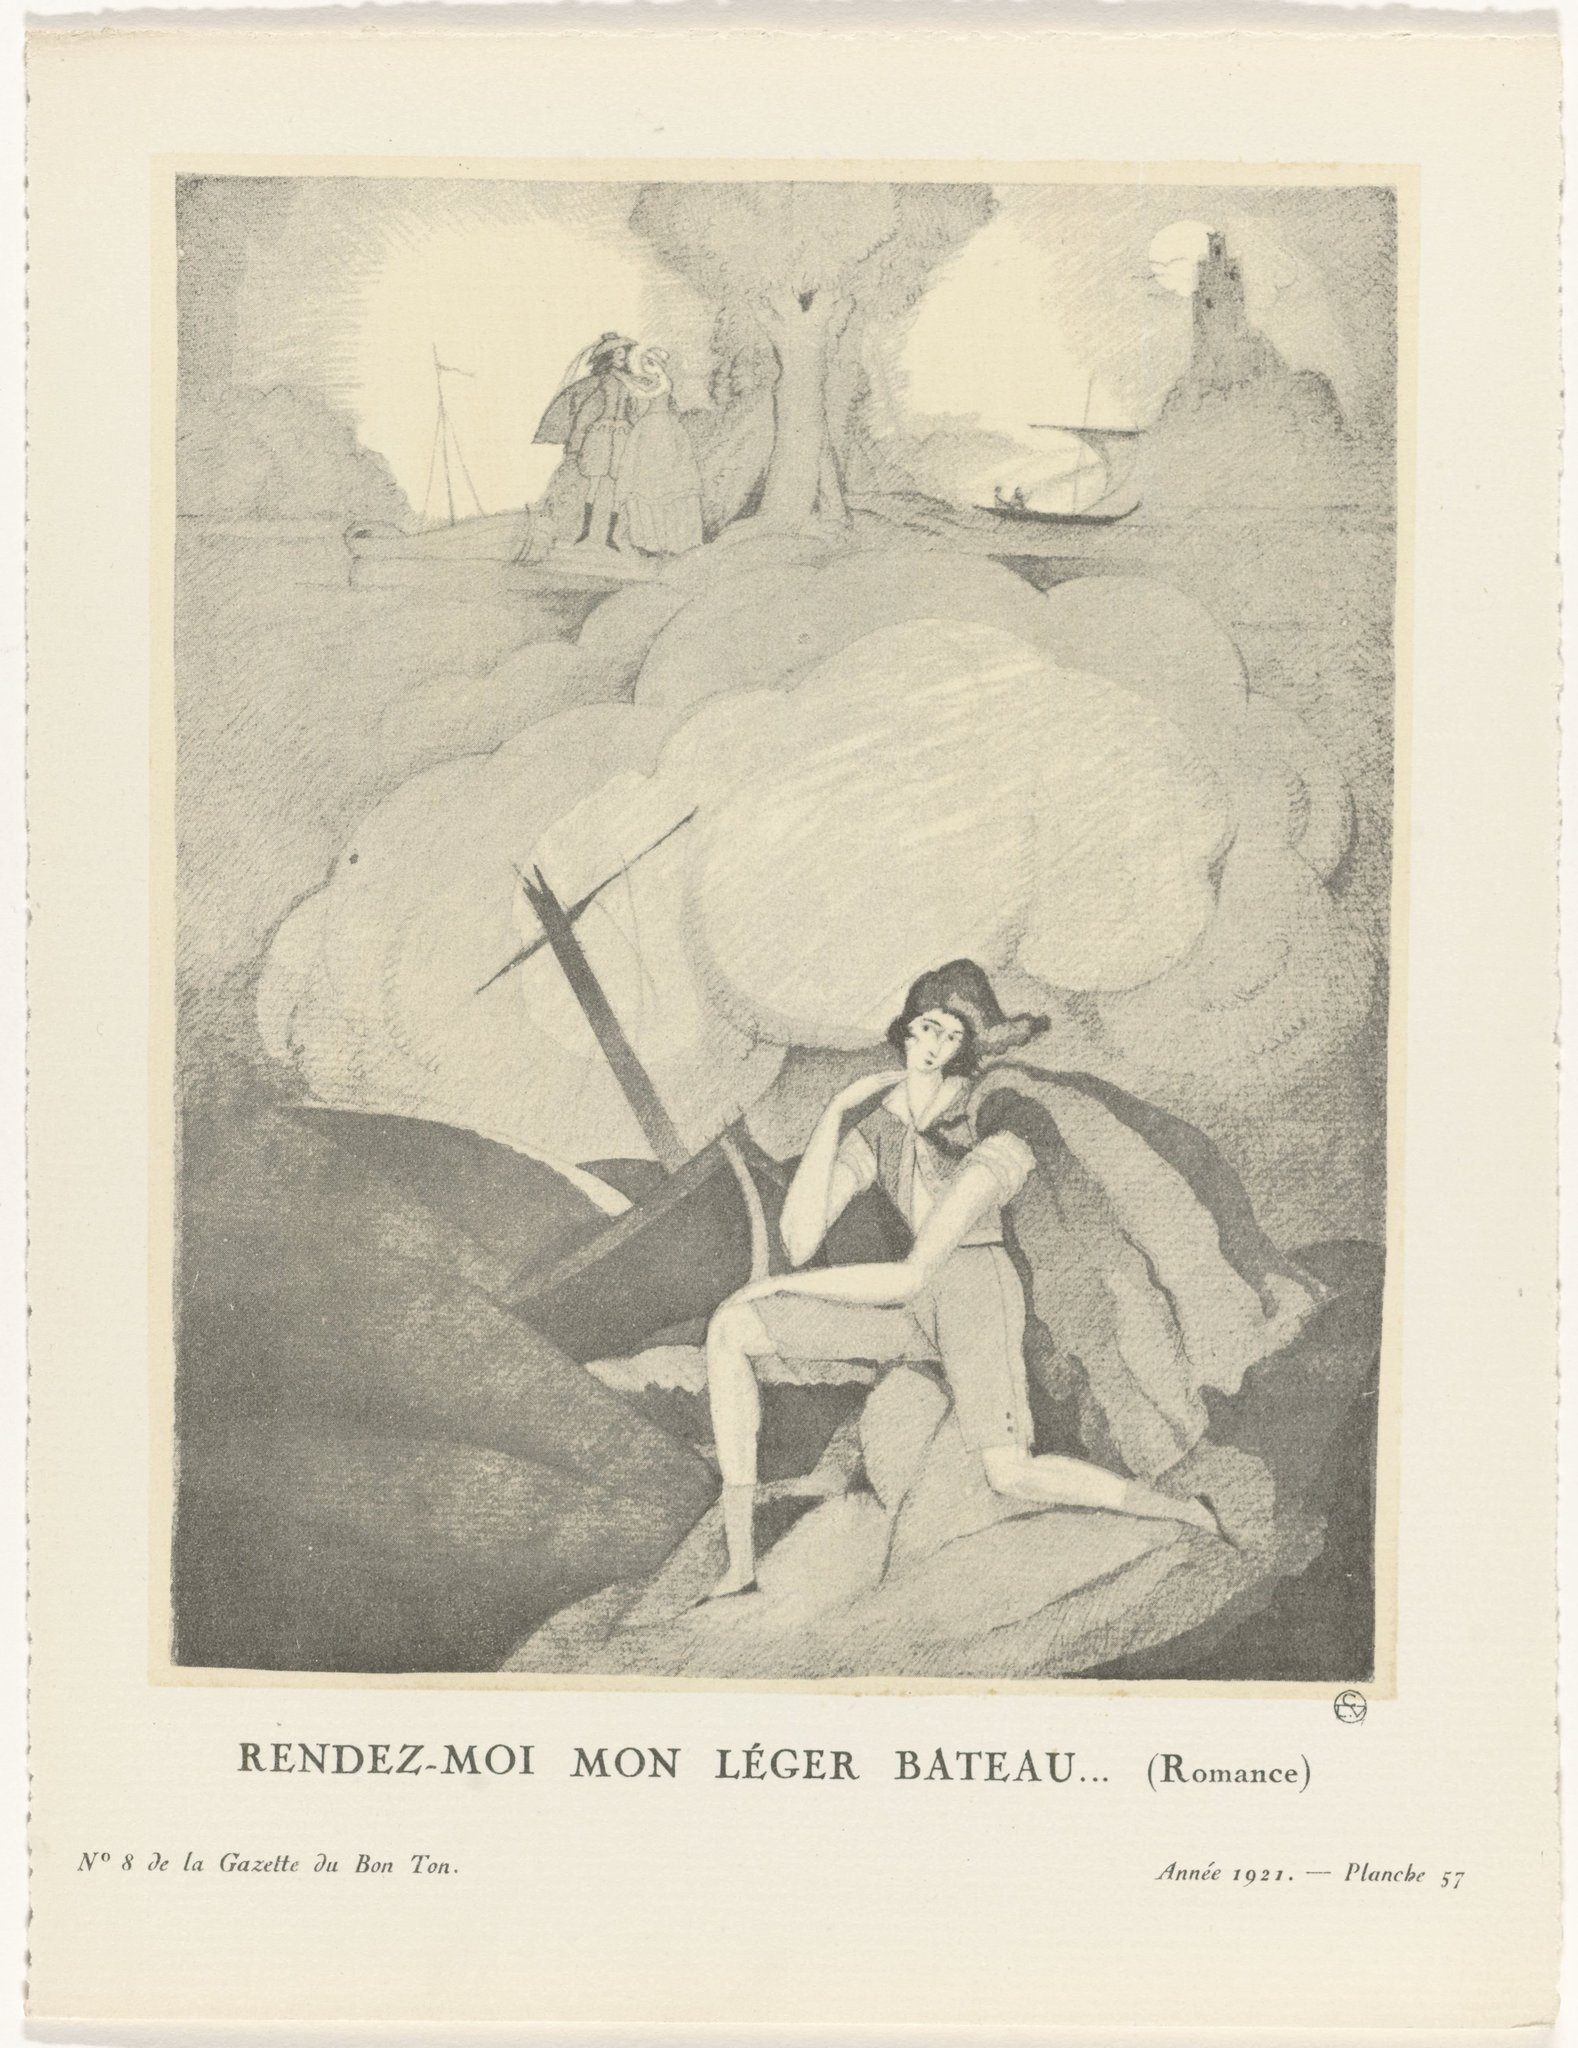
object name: fashion print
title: Gazette du Bon Ton, 1921 - No. 8 : Rendez-moi mon léger bateau... (Romance)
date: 1921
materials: paper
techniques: letterpress printing, photochemical processes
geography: paris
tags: fashion plates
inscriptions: date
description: Zittende jongeman bij een boot. Op de achtergrond twee zeilschepen en een liefdespaar. Planche 57 uit Gazette du Bon Ton 1921, No. 8.